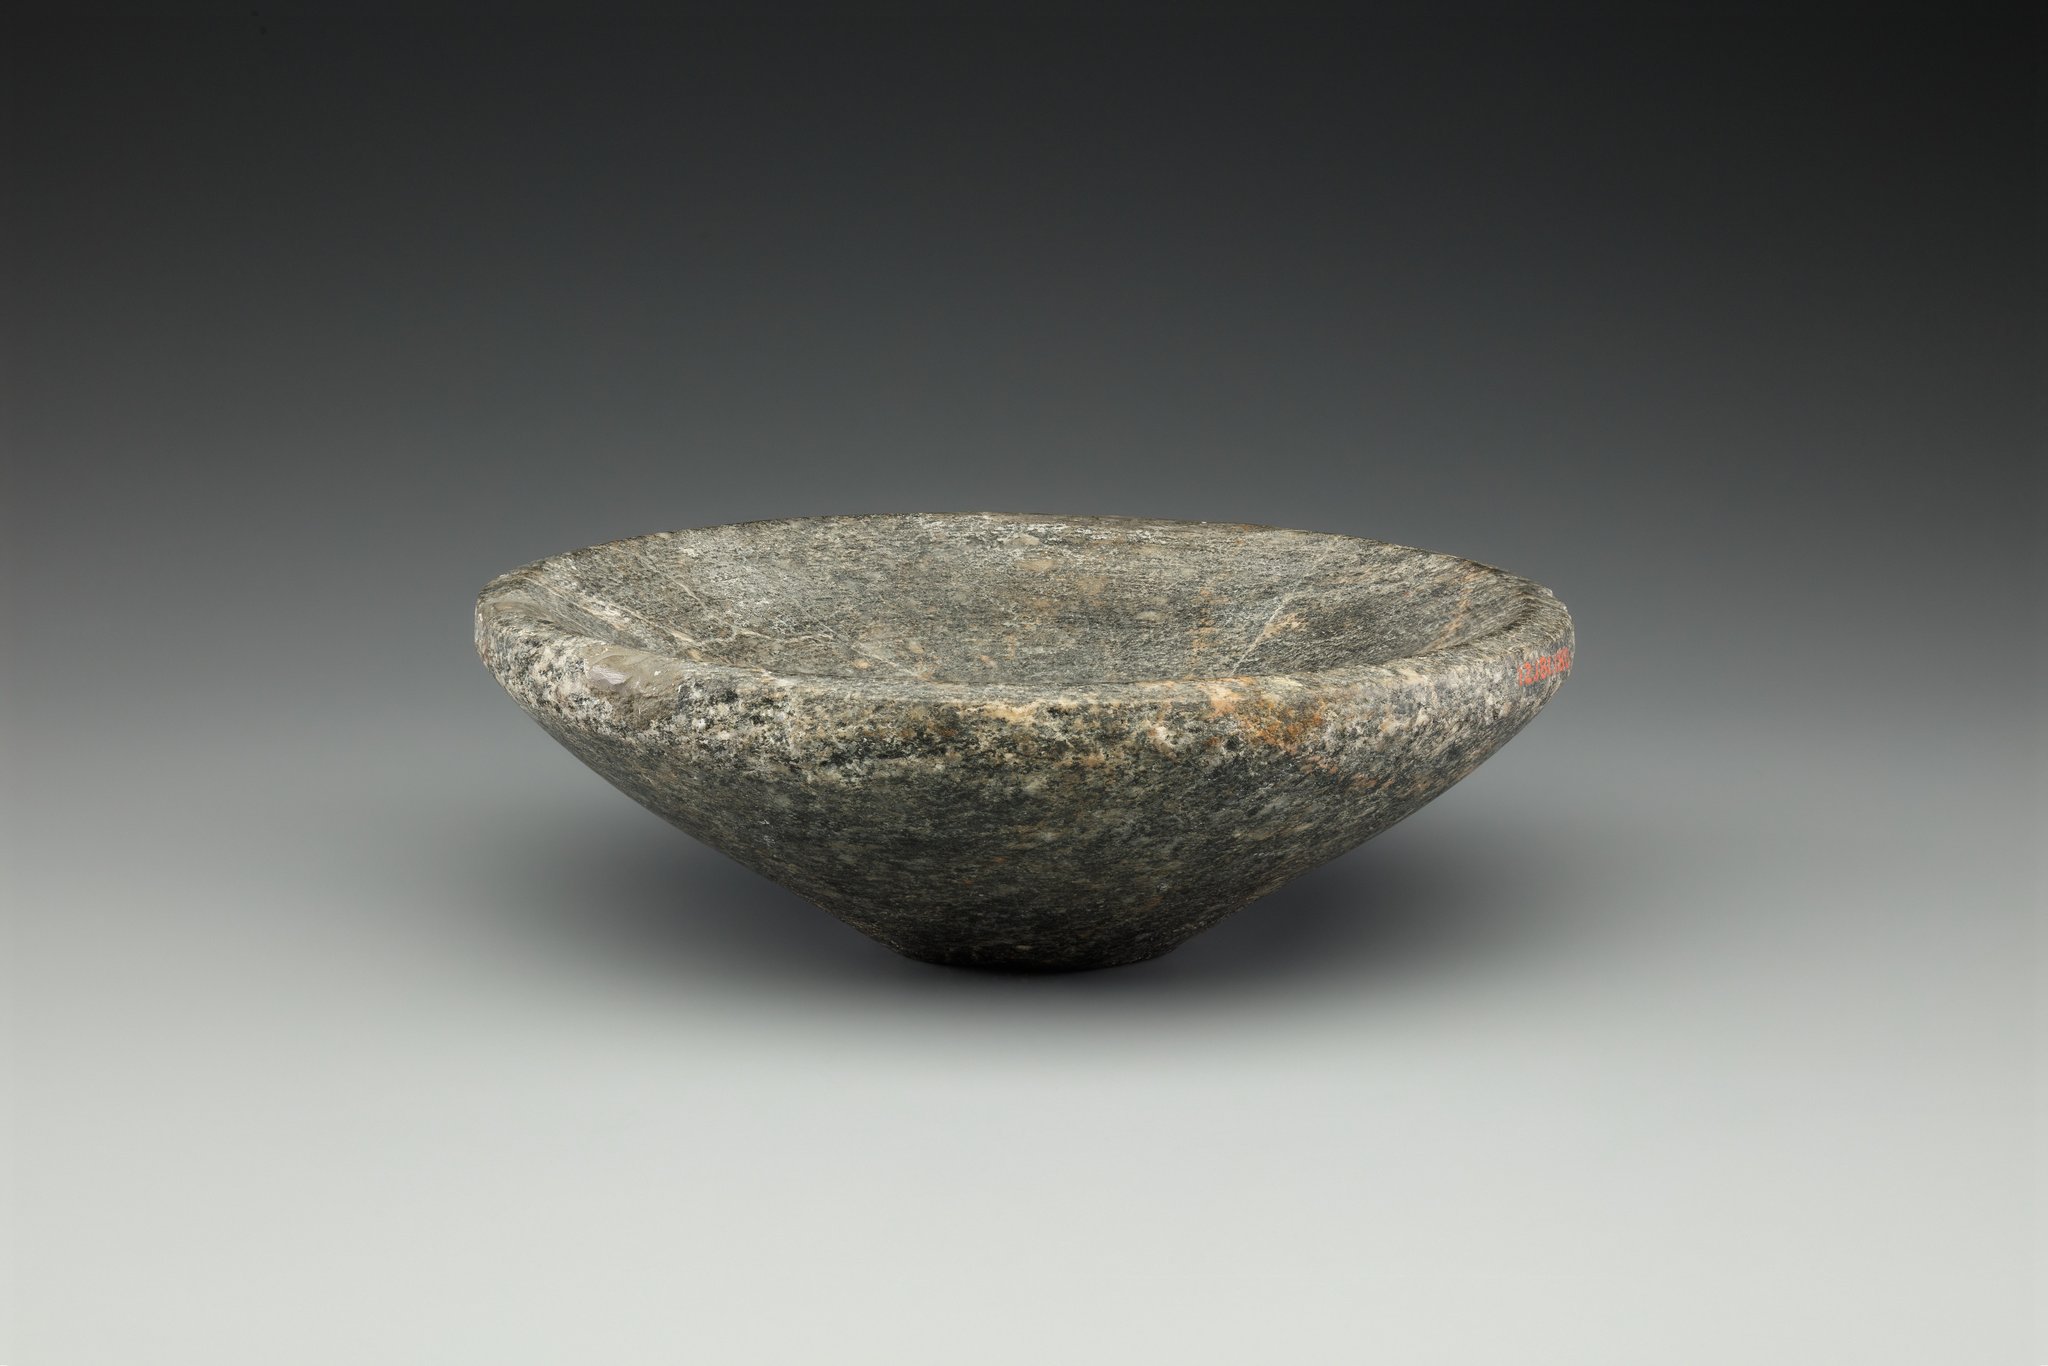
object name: bowl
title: Shallow bowl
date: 3100-2649 BCE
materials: stone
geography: egypt